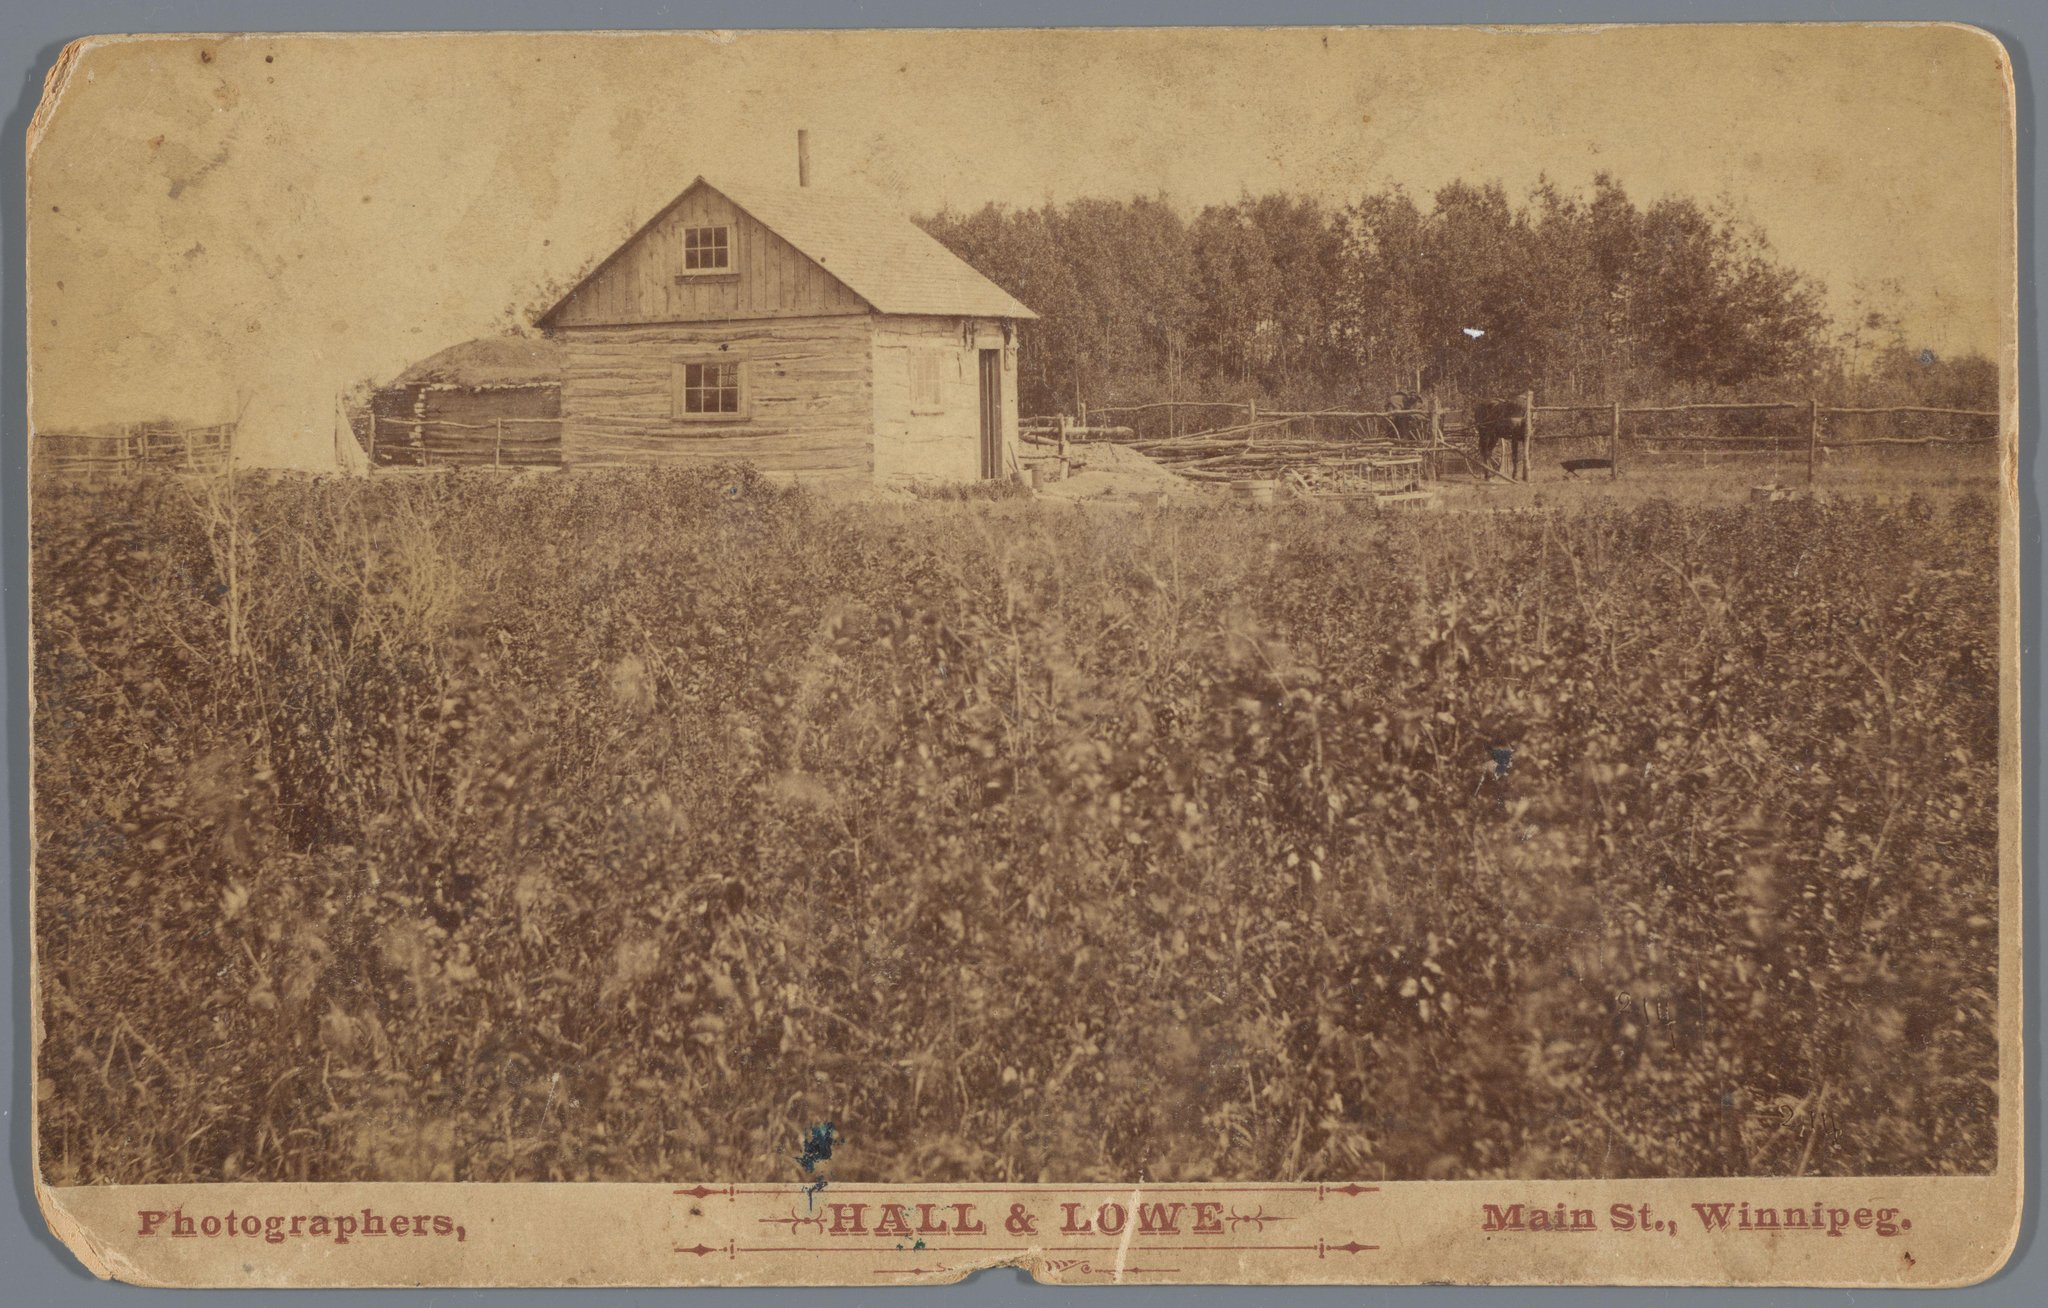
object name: cabinet photograph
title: Gezicht op Pears Farm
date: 1890-1900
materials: photographic support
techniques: albumen print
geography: winnipeg